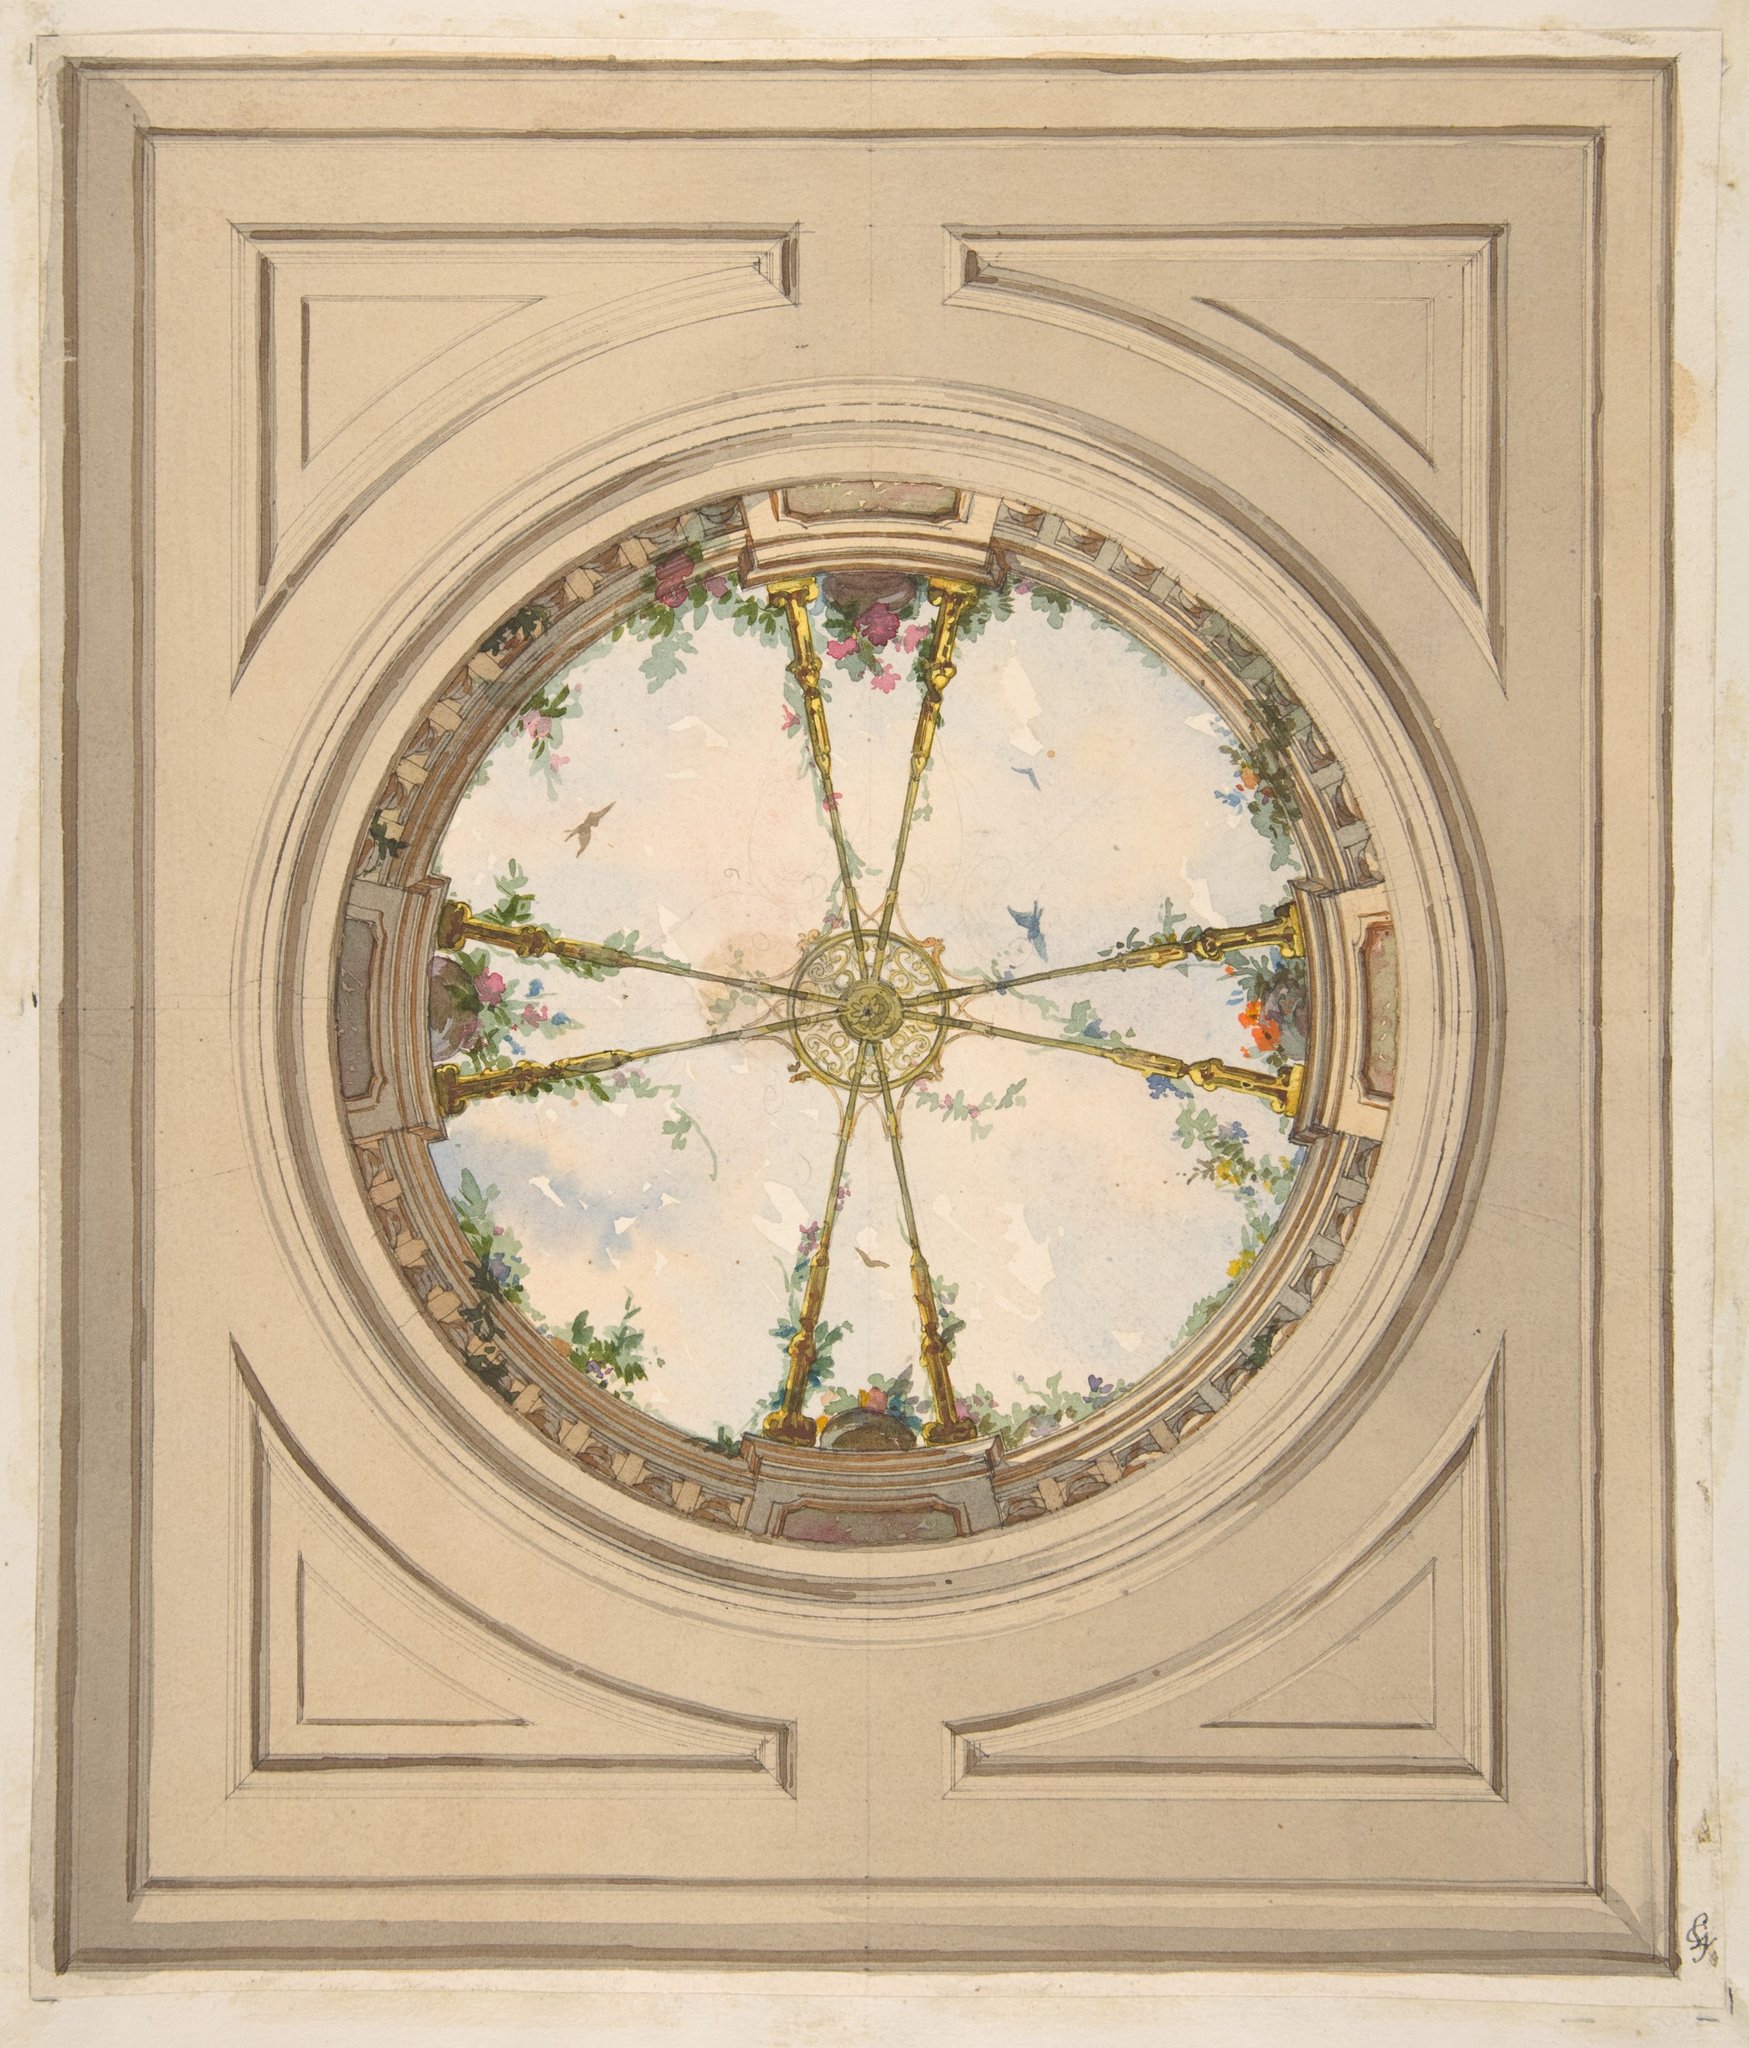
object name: drawing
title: Design for a ceiling painted with clouds and trellis work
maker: jules-edmond-charles lachaise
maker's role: artist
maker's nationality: french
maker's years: 1897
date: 1851-1900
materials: graphite, ink, watercolor, paper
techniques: pen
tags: birds,ceilings